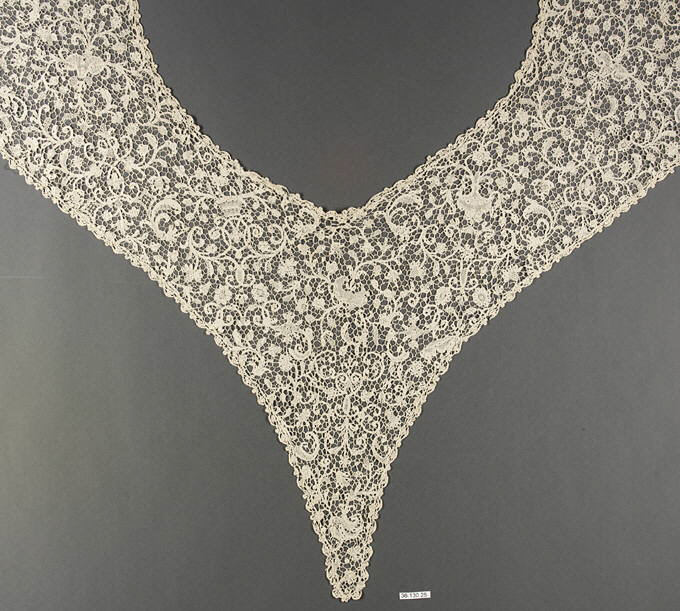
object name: bertha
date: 1701-1800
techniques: lace